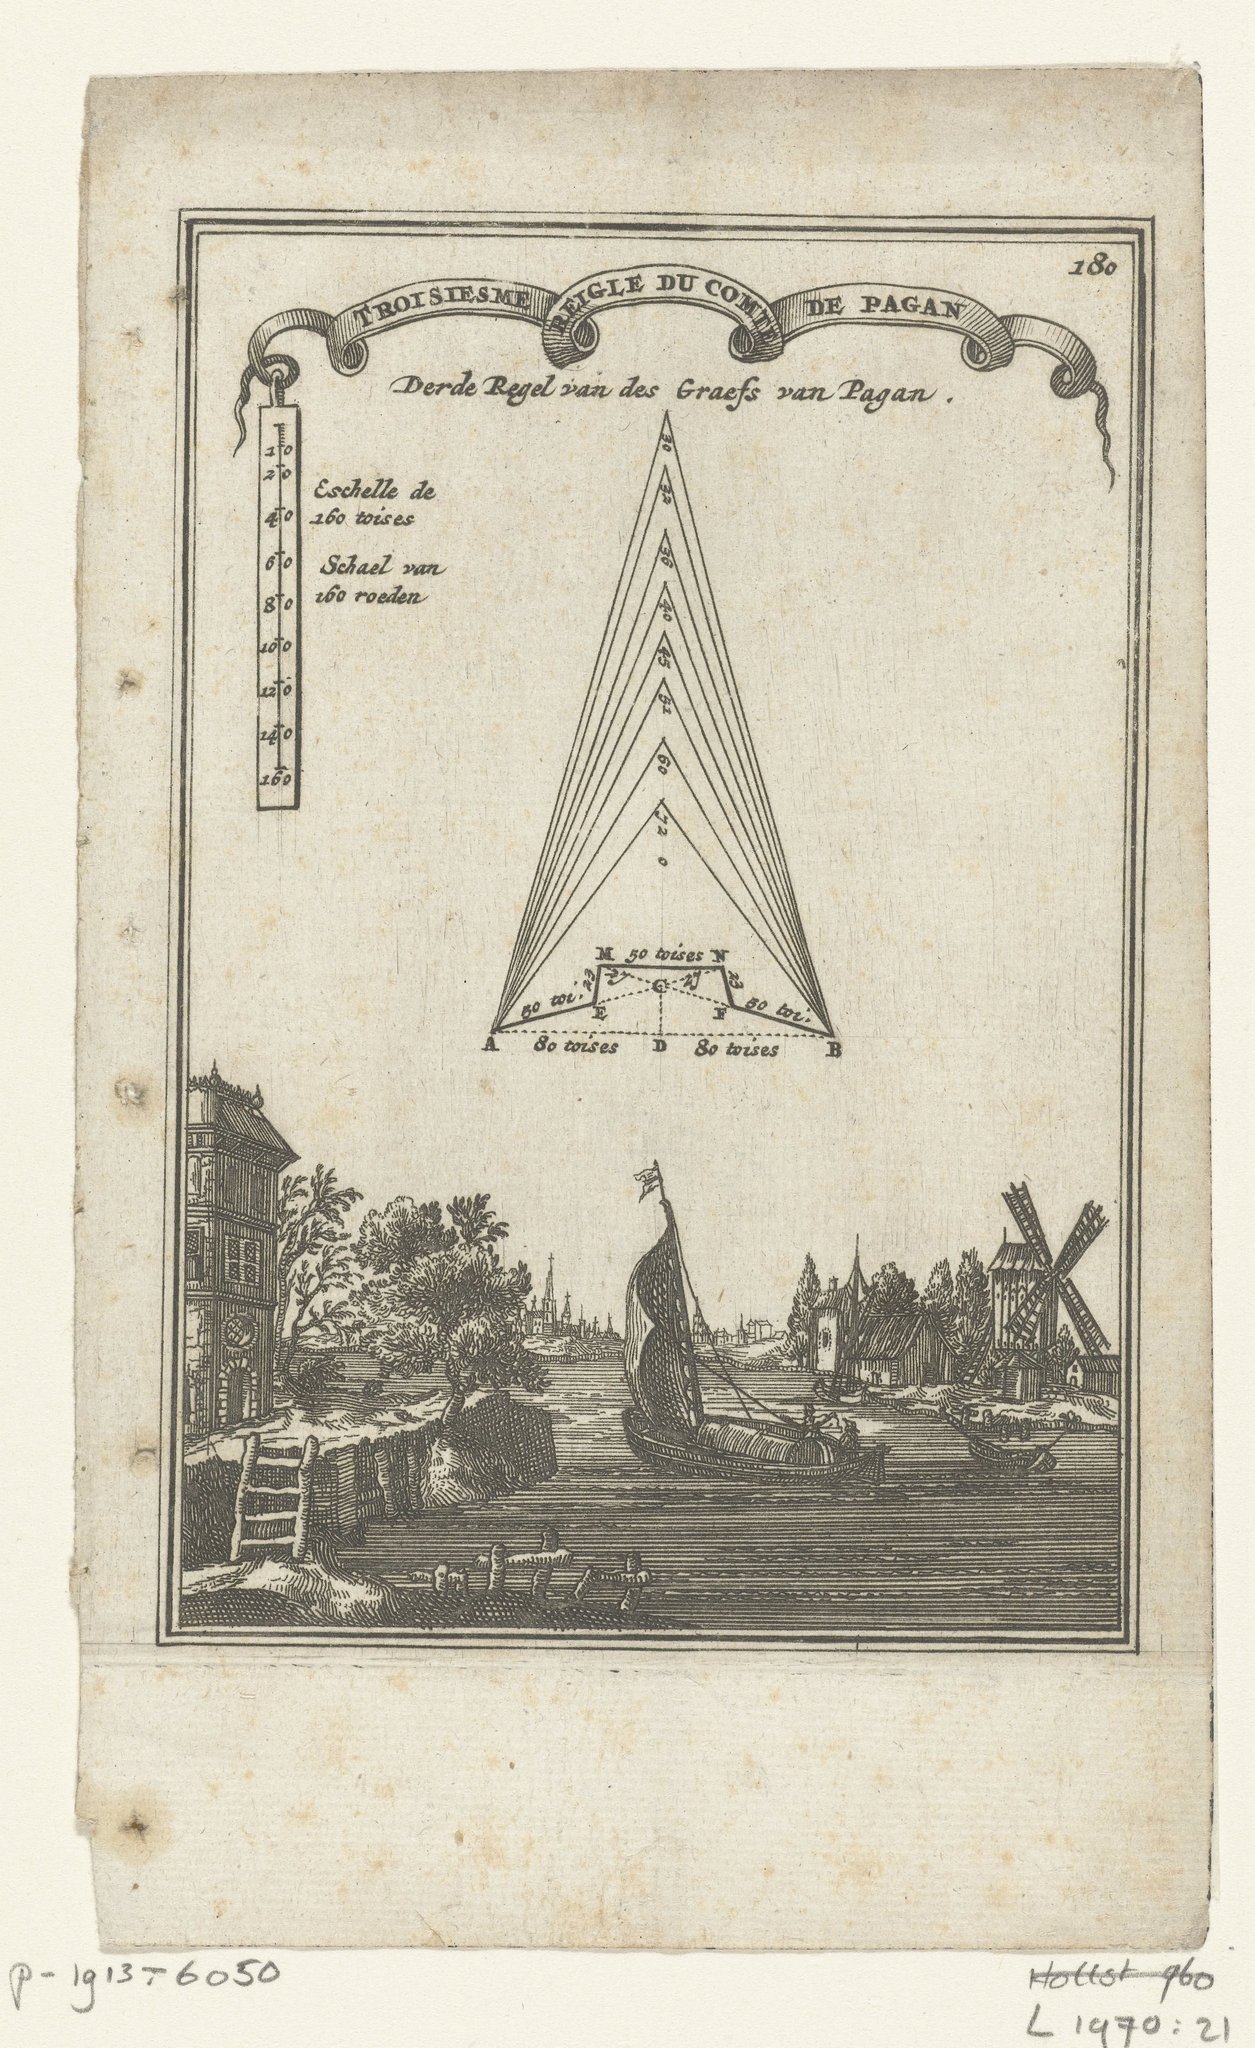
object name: book illustration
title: Illustratie voor 'Den Arbeid van Mars' van Allain Manesson Mallet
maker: romeyn de hooghe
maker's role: draughtsman, goldsmith, painter, print maker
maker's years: 1645-1708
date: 1672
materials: paper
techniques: etching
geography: amsterdam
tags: city-view, and landscape with man-made constructions, river, ships (in general), fortifications, military engineering, mathematics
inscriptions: collector's mark: Lugt 2228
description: Wiskundige figuur. Daaronder een gezicht op een molen en enkele huizen aan een rivier, waarop ene boot zeilt. In de hoek rechtsboven het cijfer 180 (= het nummer van de pagina in het boek waartegenover de illustratie geplaatst is).